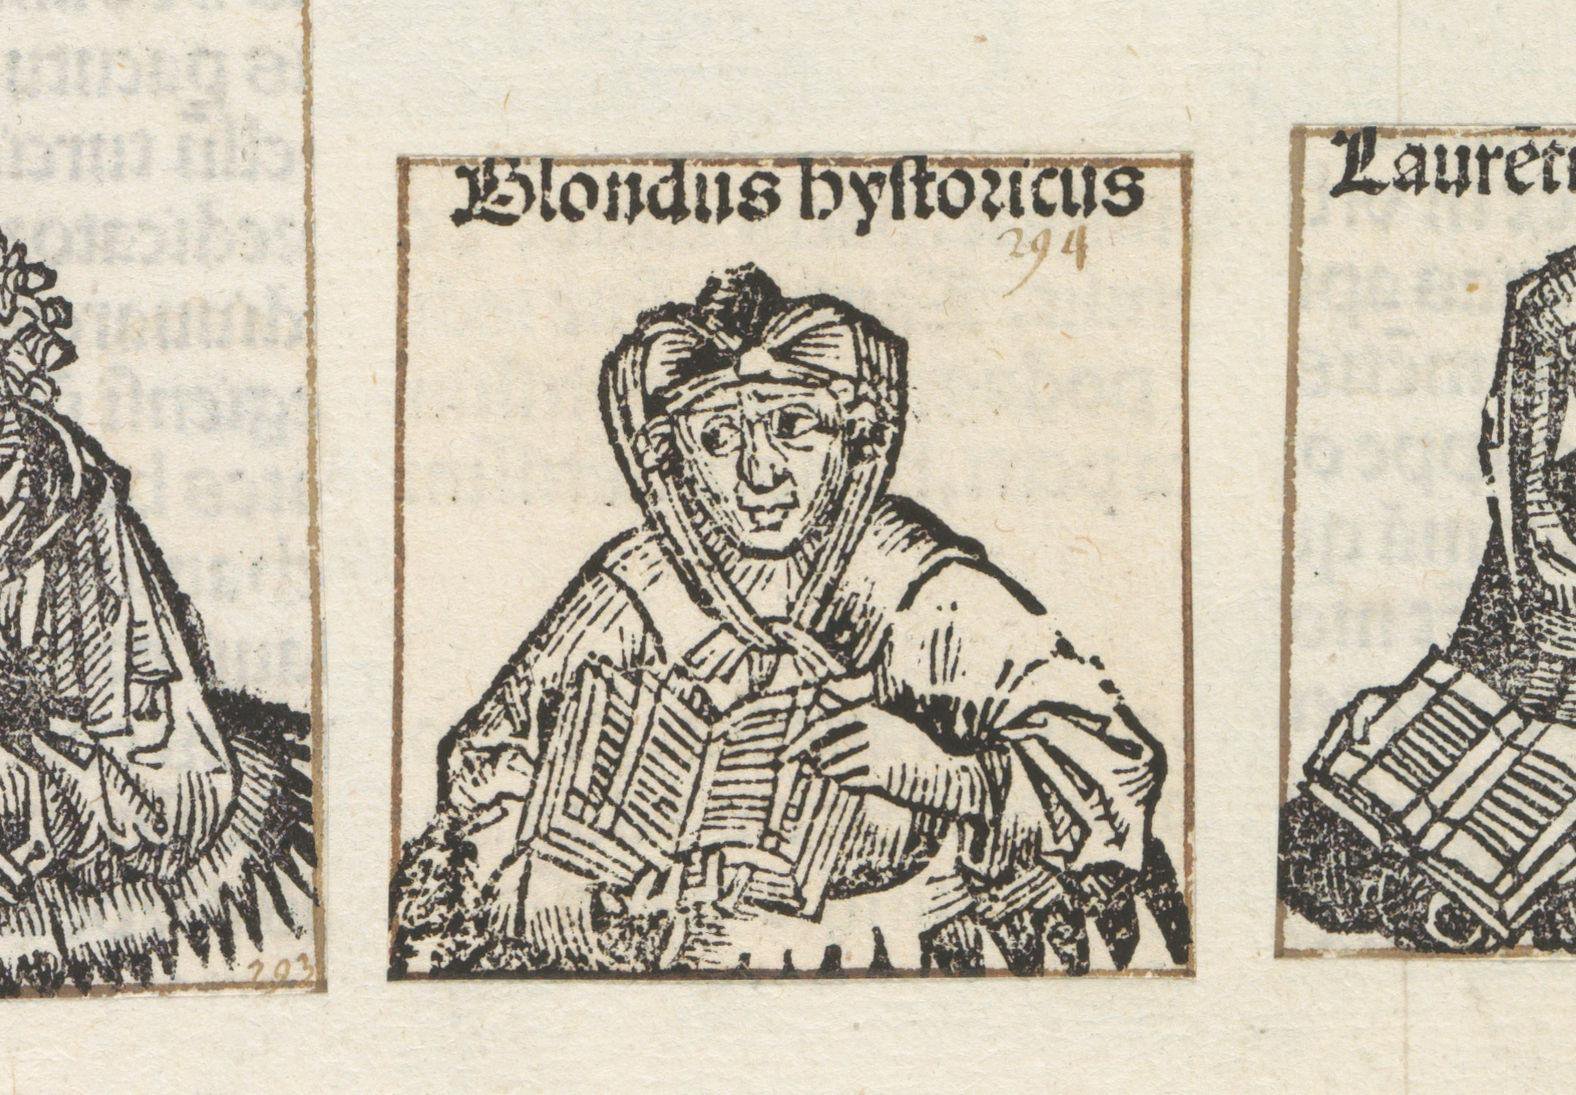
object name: print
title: Blondus hystoricus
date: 1493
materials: paper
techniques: letterpress printing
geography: nuremberg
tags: rome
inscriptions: inscription: ‘293’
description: De houtsnede wordt herhaaldelijk gebruikt als boekillustratie in de Liber Chronicarum (of Neurenbergkroniek) van Hartmann Schedel, verschenen in het Latijn en Duits in 1493. Zie de Latijnse uitgave, folio 246r.